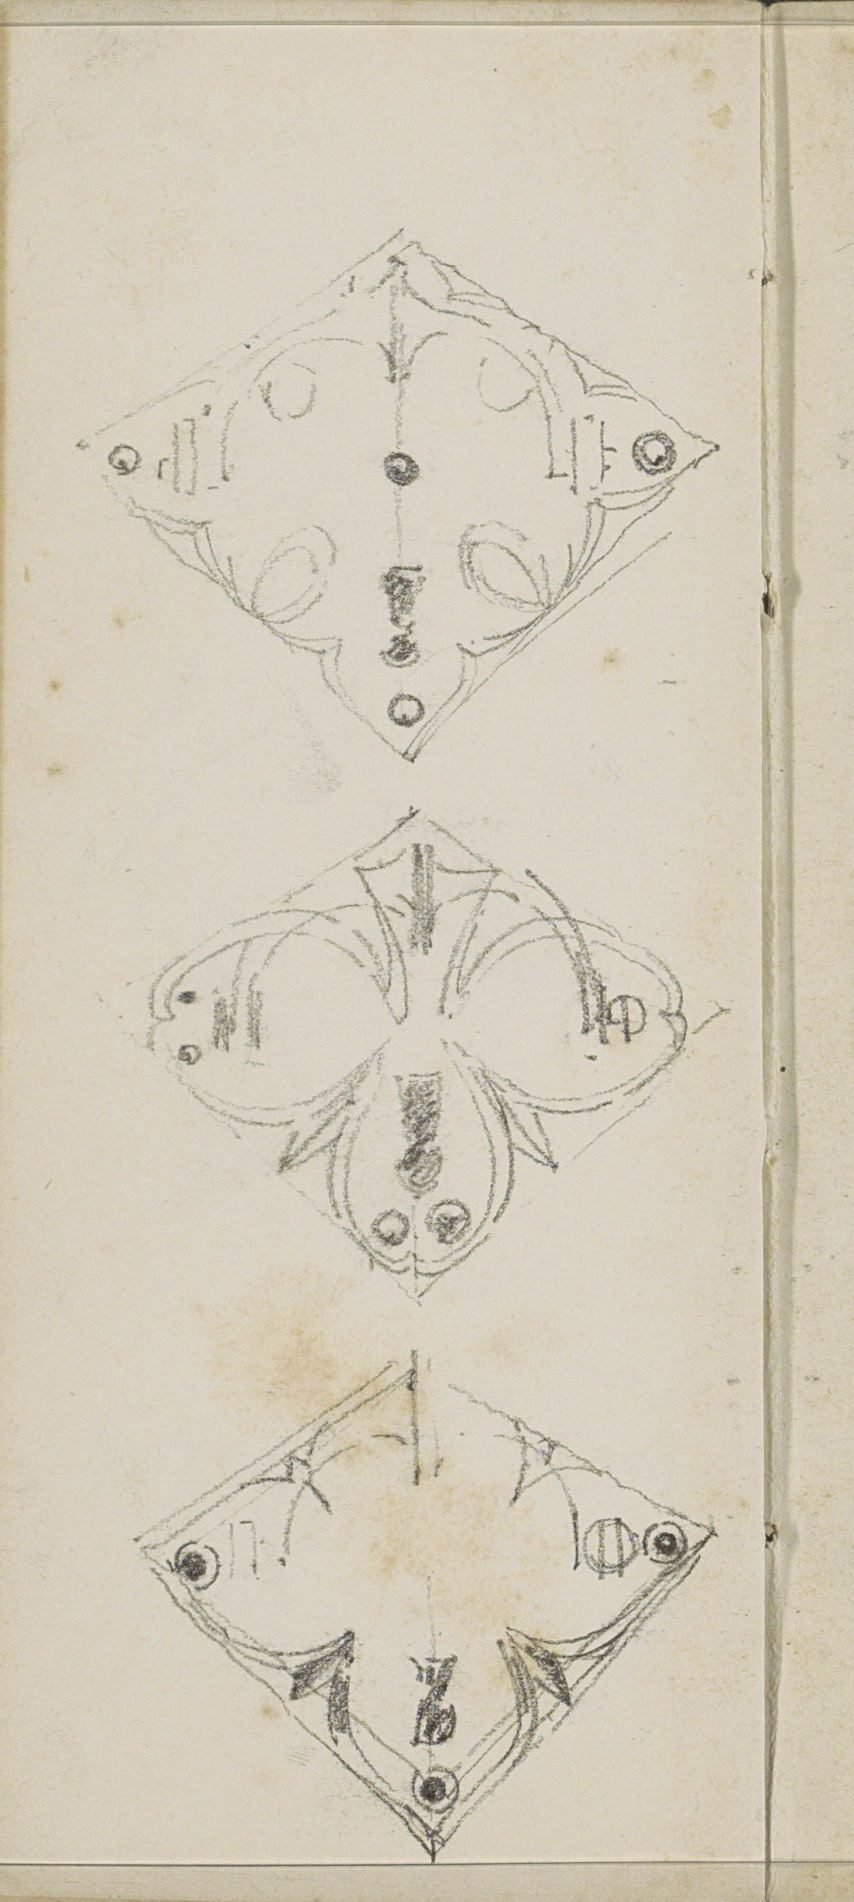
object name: sketchbook leaf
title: Ruitvormige ornamenten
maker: gerrit willem dijsselhof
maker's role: designer, draughtsman, print maker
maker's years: 1866-1924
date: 1876-1924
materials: chalk, paper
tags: ornaments ~ art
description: Blad 39 verso uit een schetsboek met 40 bladen.